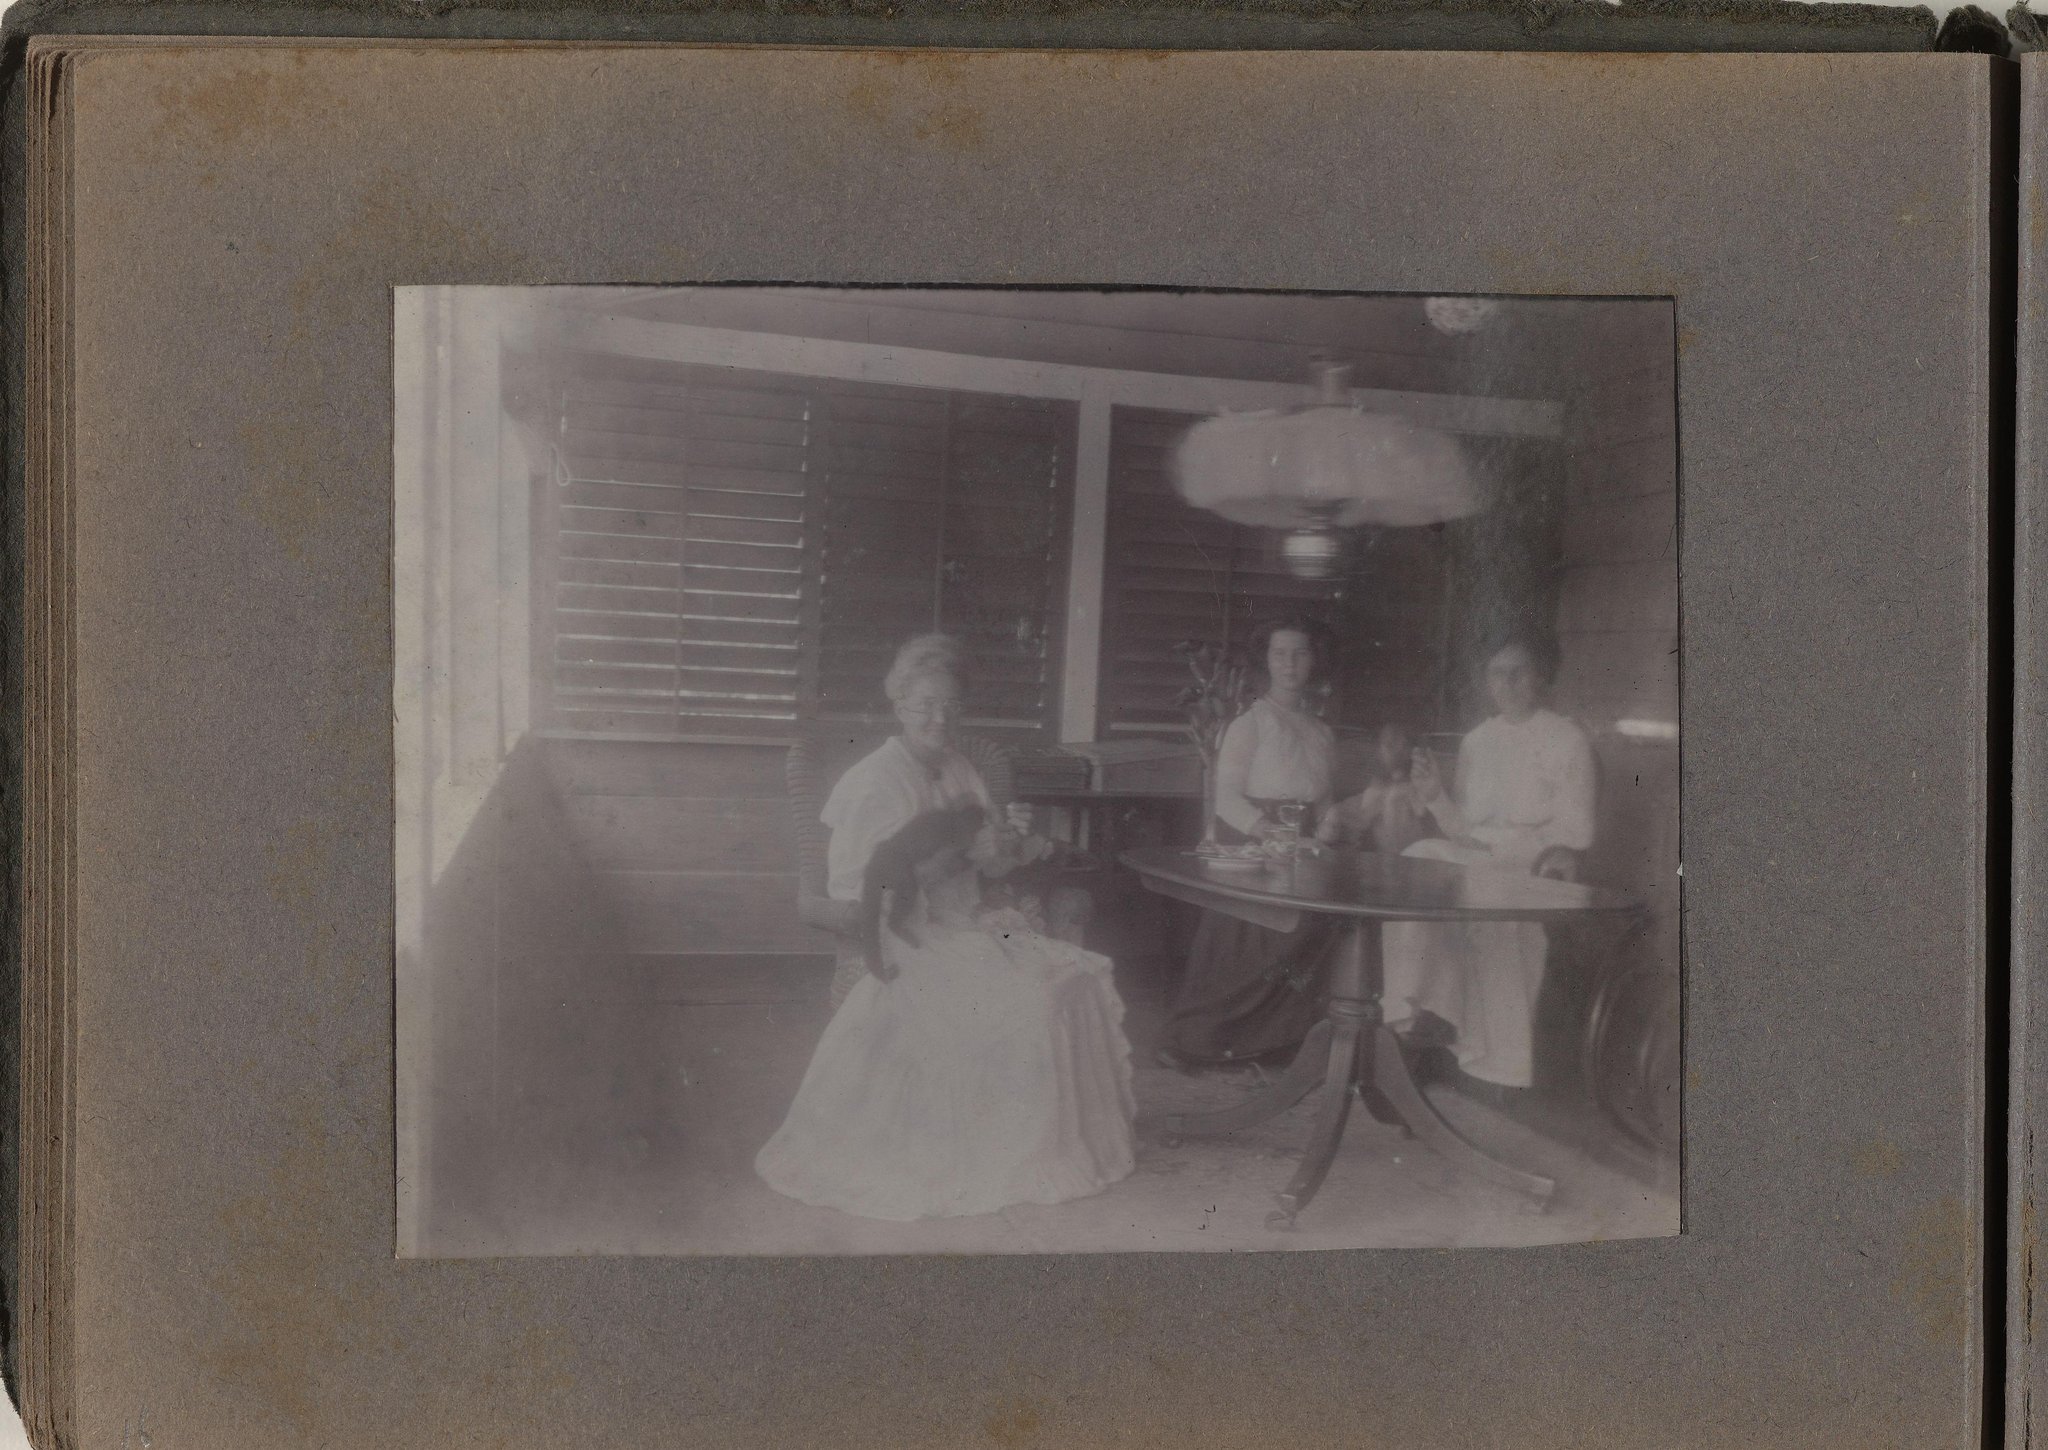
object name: photograph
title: Vrouwen op veranda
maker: Anonymous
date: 1910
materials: photographic support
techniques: gelatin silver print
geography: suriname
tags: plantation, suriname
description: Drie vrouwen zittend op de veranda van een huis op Plantage Clevia. Waarschijnlijk Maria Gonggrijp met Sacha Croese, links een oudere vrouw met een aapje. Onderdeel van het fotoalbum over de familie Gonggrijp op de plantages Clevia en Morgenstond in Suriname rond 1910.